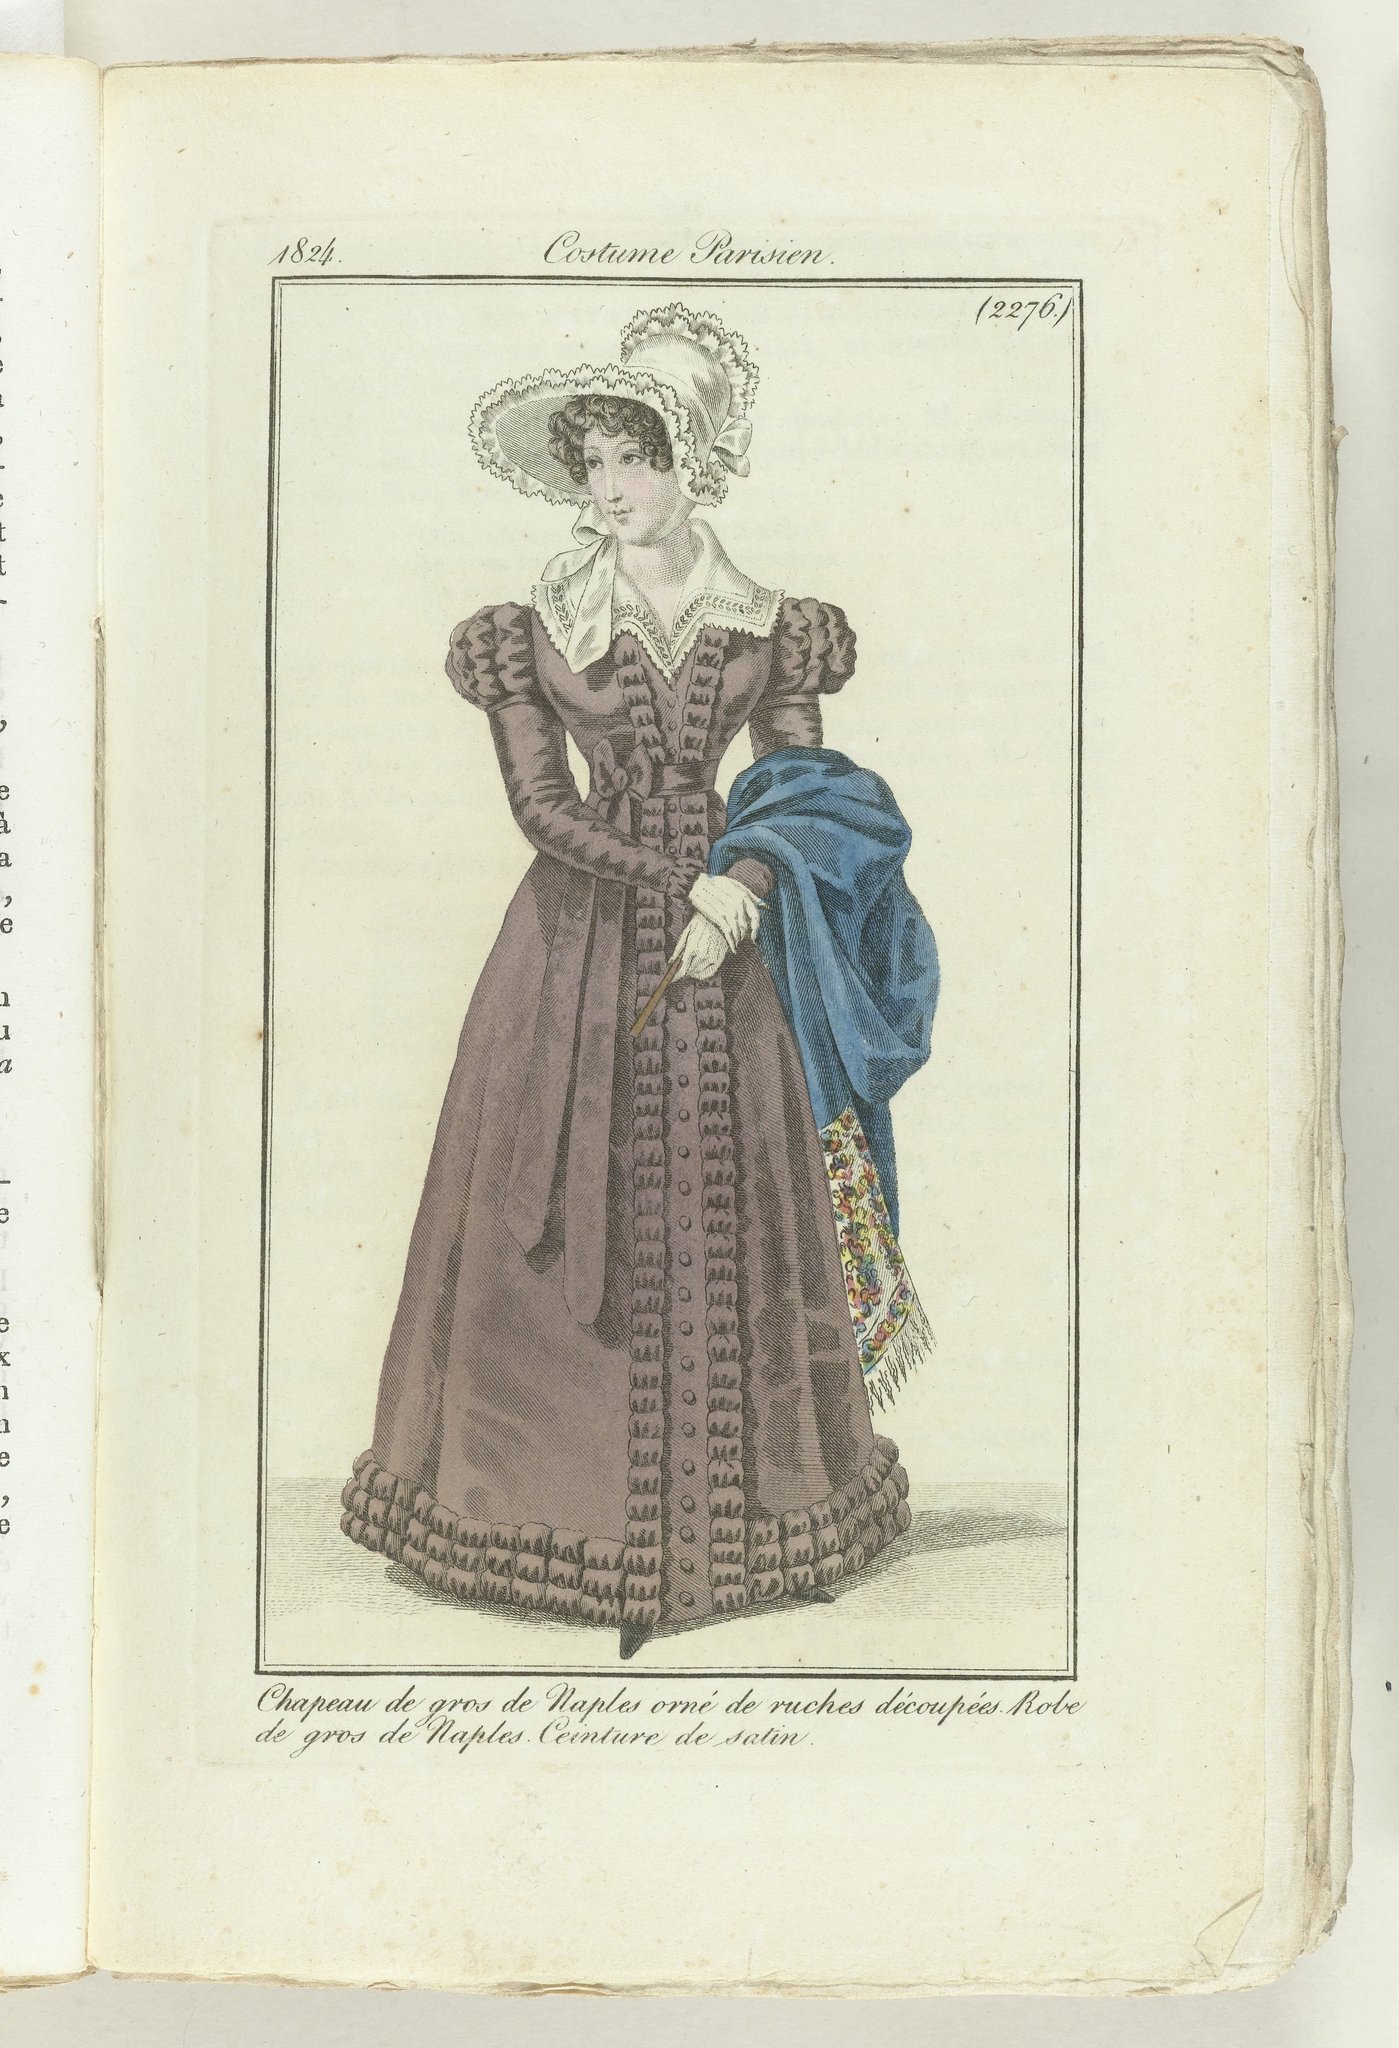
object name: fashion print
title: Journal des Dames et des Modes 1824, Costume Parisien (2276)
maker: Anonymous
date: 1824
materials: paper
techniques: etching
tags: fashion plates, clothes, costume (+ women's clothes)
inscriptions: date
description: Prent uit het tijdschrift Journal des Dames et des Modes, 1824.